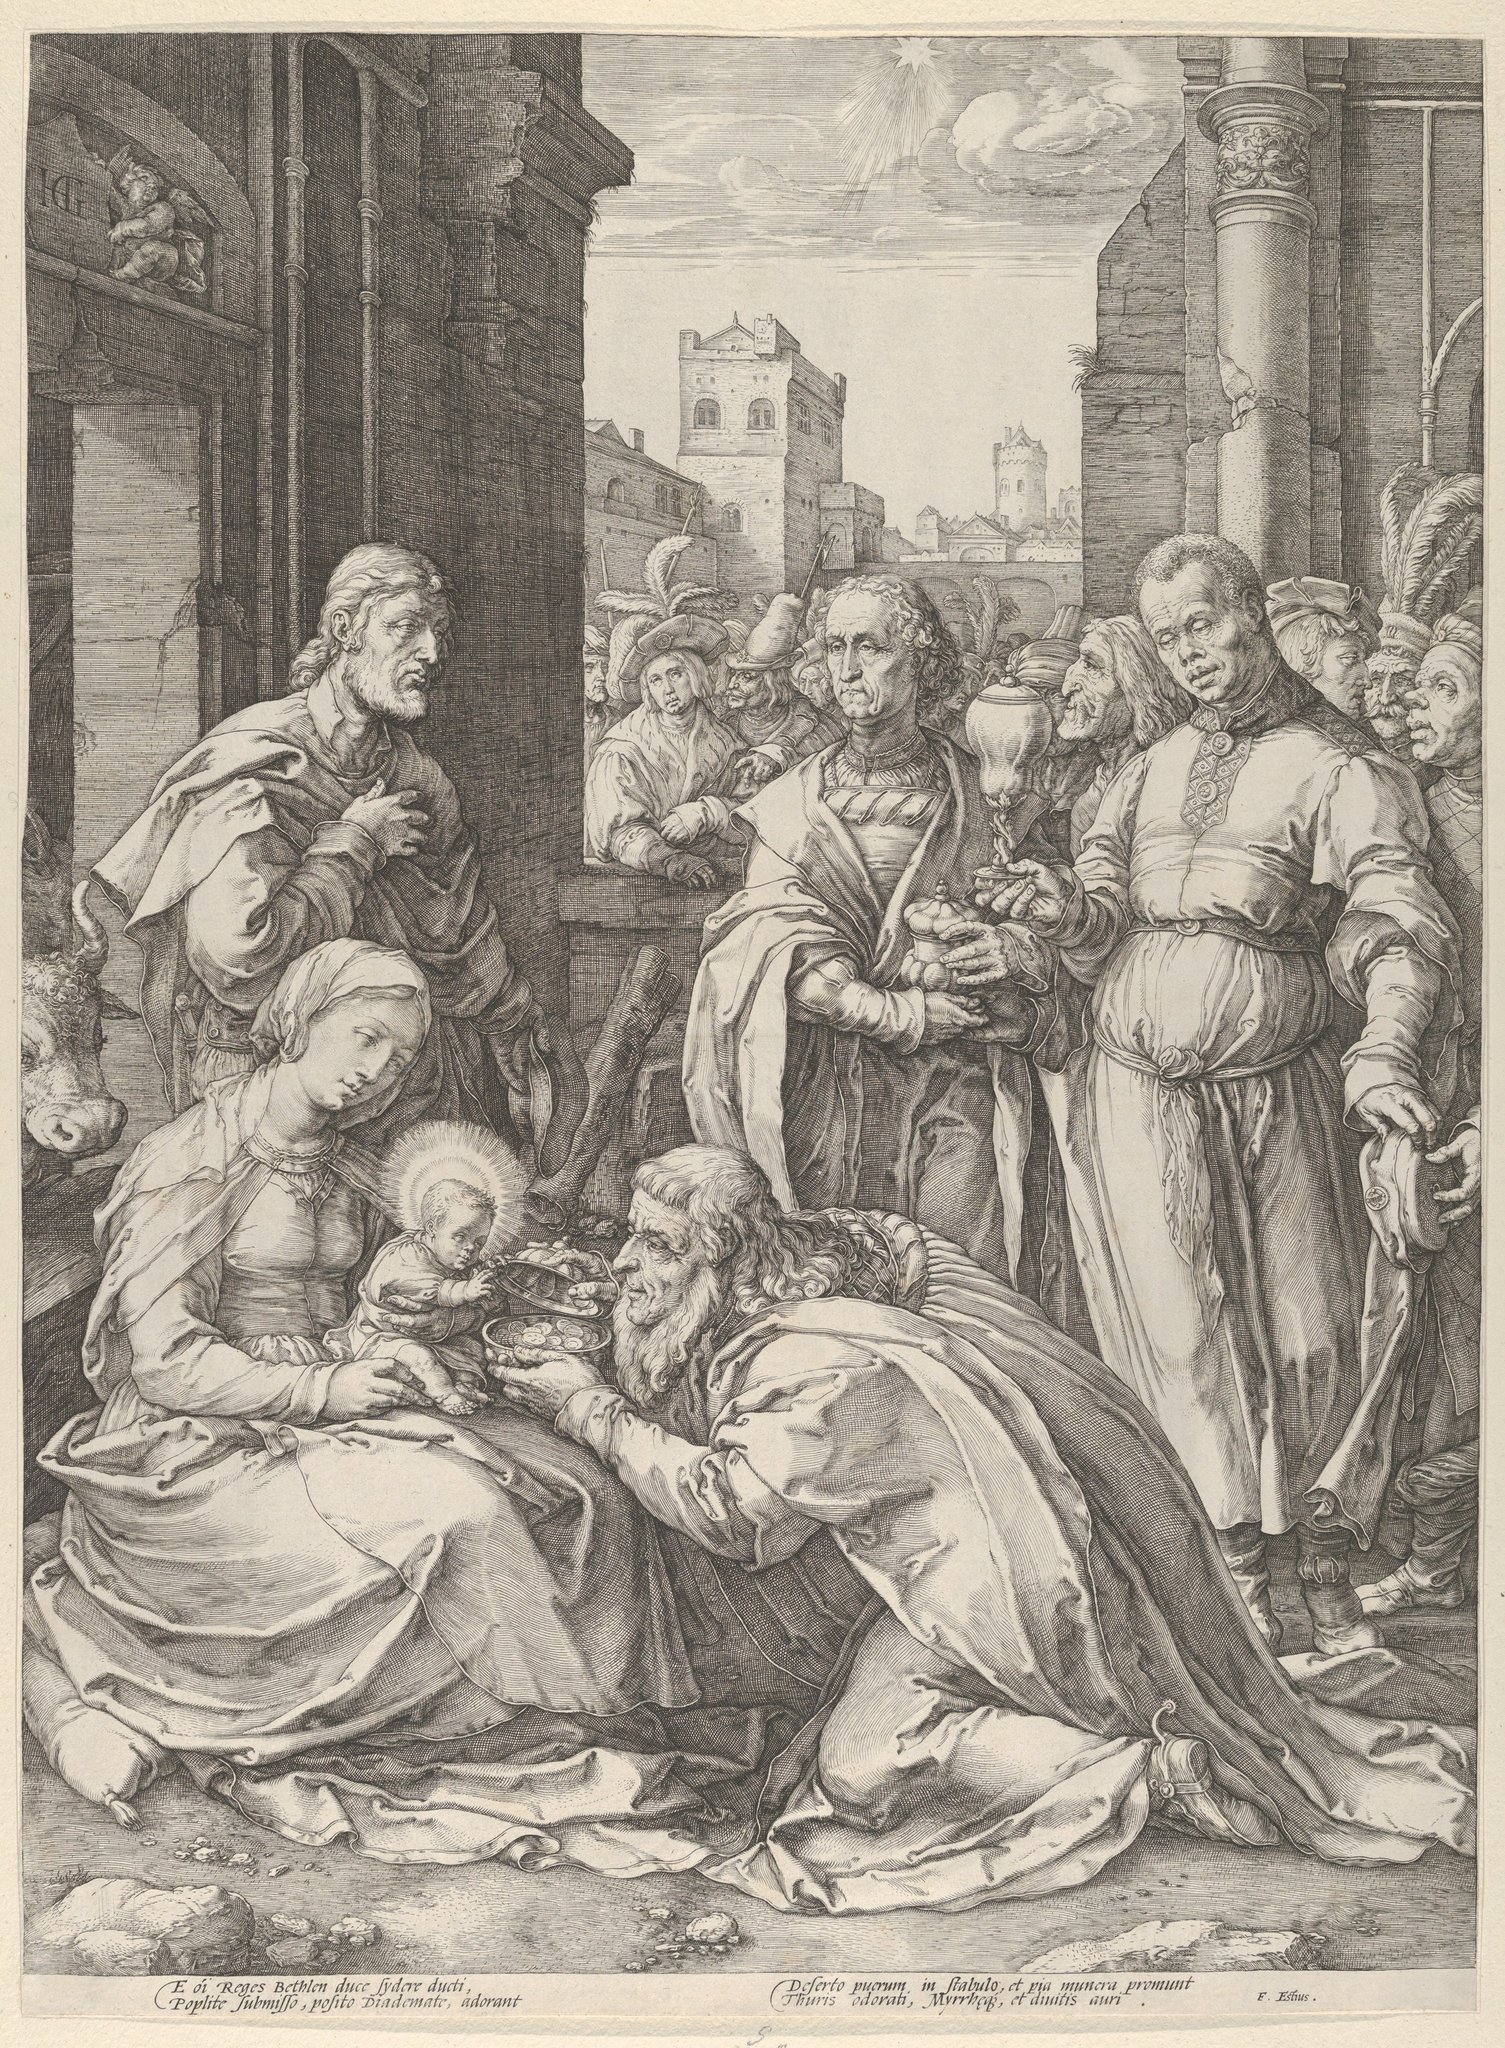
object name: print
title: Adoration of the Magi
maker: hendrick goltzius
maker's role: artist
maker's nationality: netherlandish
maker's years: 1558-1617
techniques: engraving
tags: infants,men,women,adoration of the magi,crowd